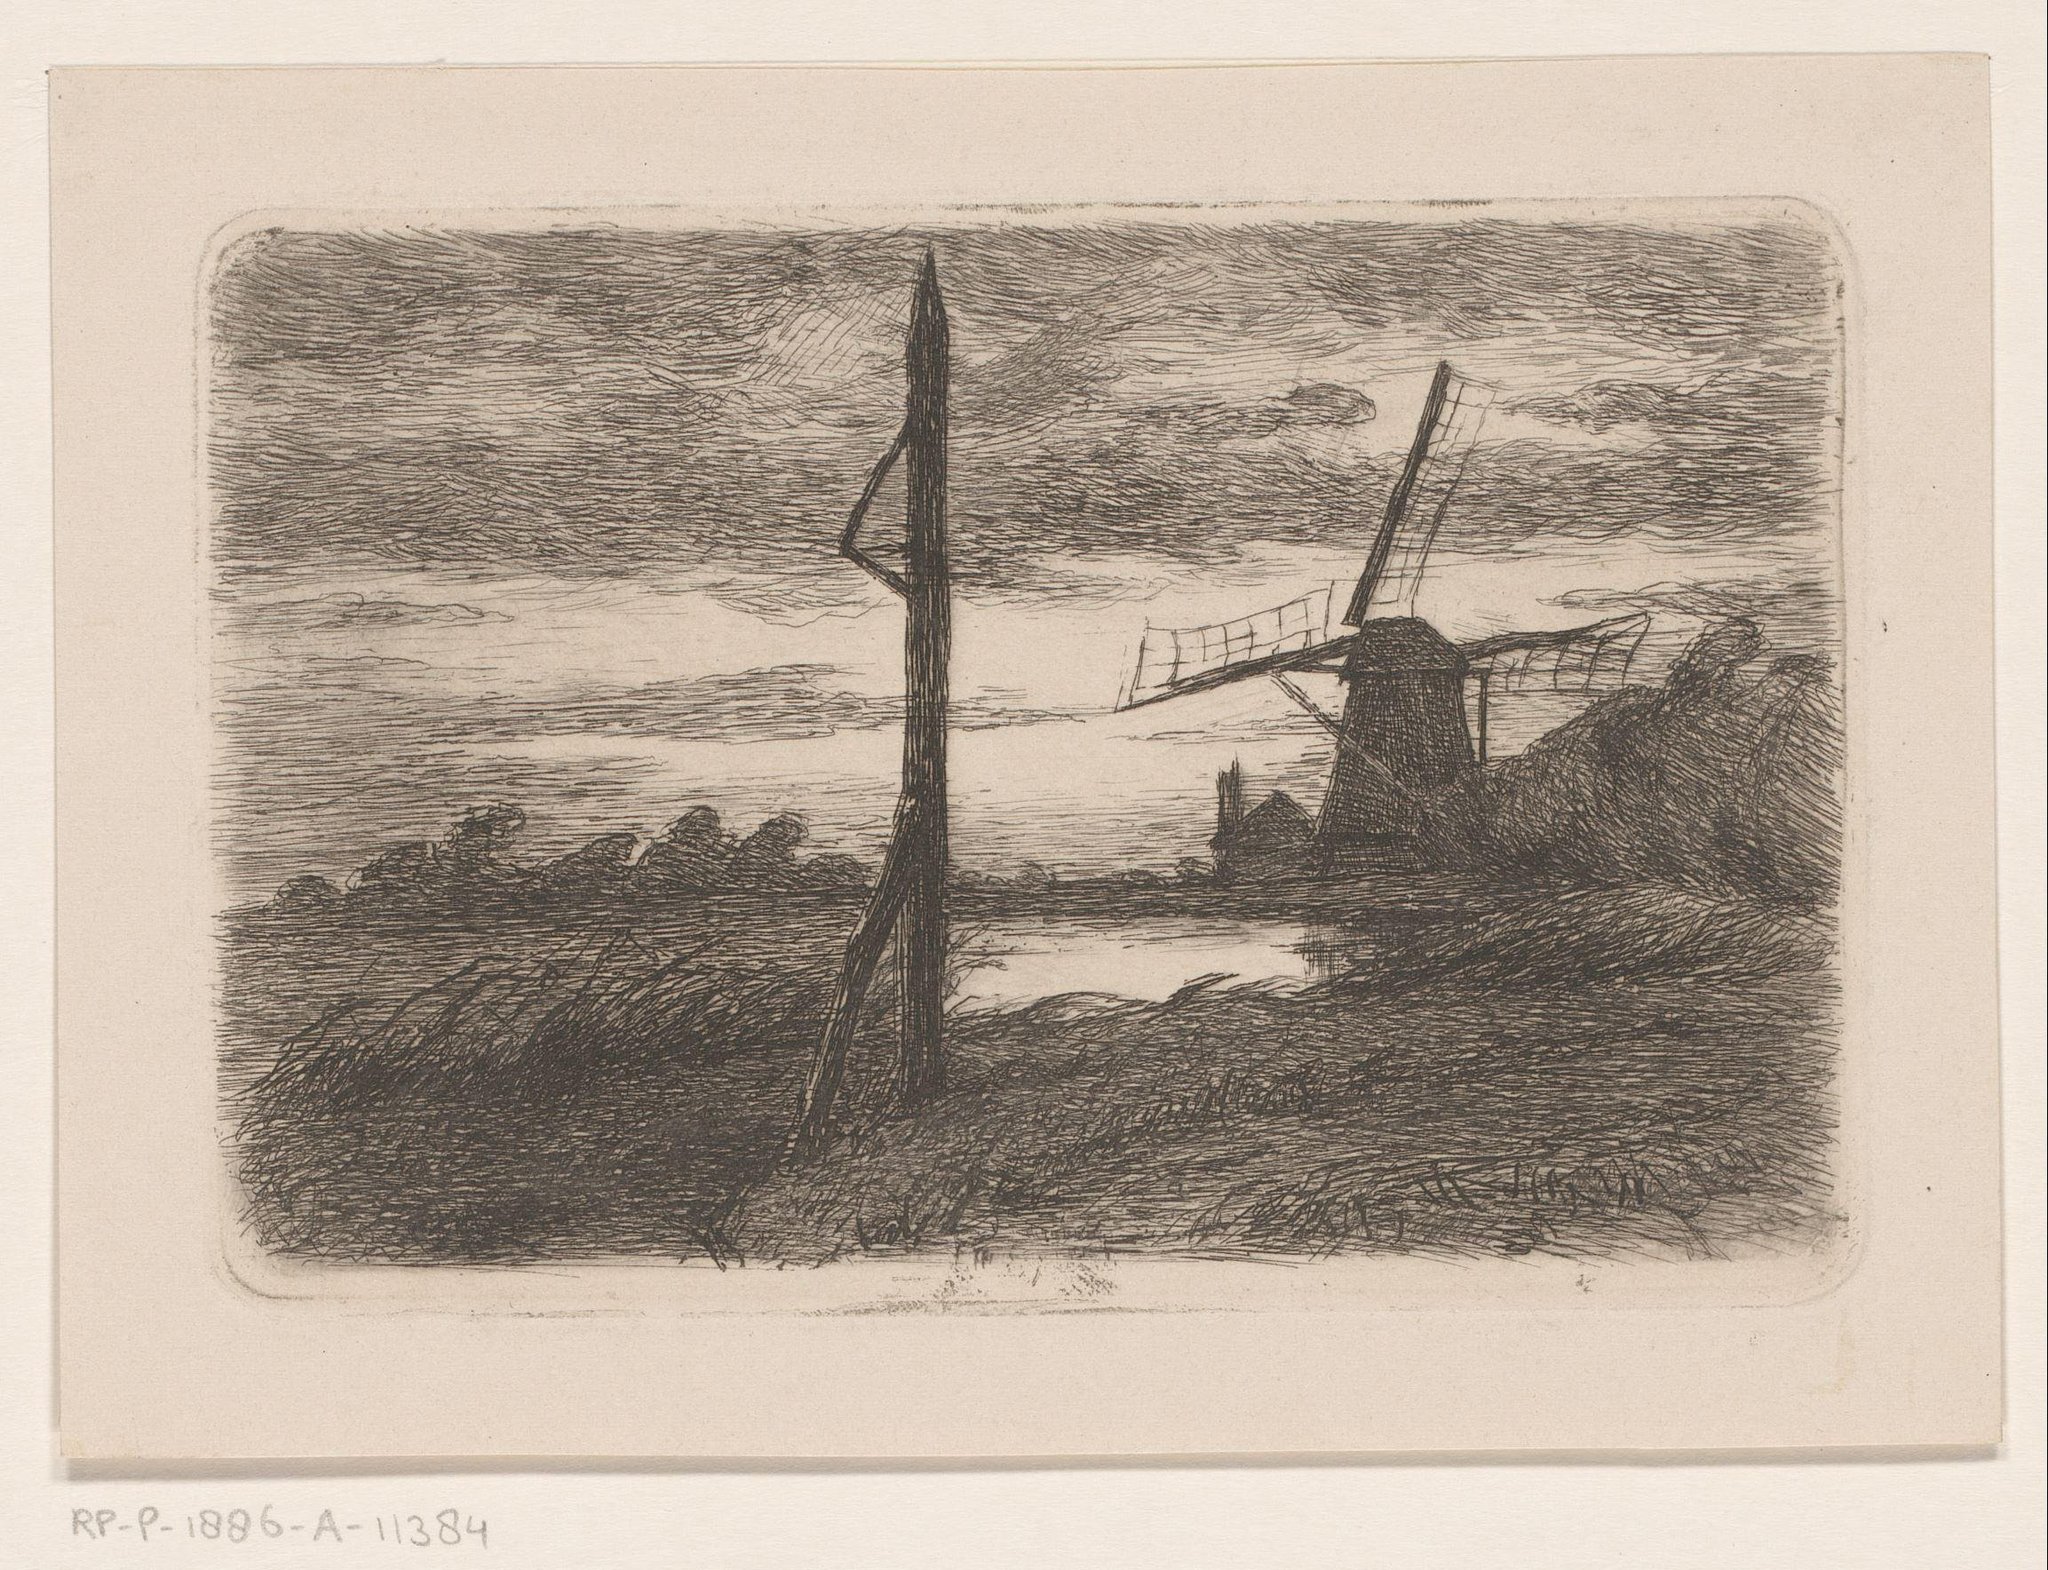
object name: print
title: Riviergezicht met molen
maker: wilhelmus johannes steenhoff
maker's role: draughtsman, print maker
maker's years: 1863-1932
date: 1873-1886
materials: paper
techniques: etching, intaglio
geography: netherlands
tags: river, windmill in landscape, hay-stack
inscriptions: collector's mark: Lugt 2228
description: Op de voorgrond in het midden aan de waterkant een rolpaal. Op de achtergrond een molen en een hooiberg.